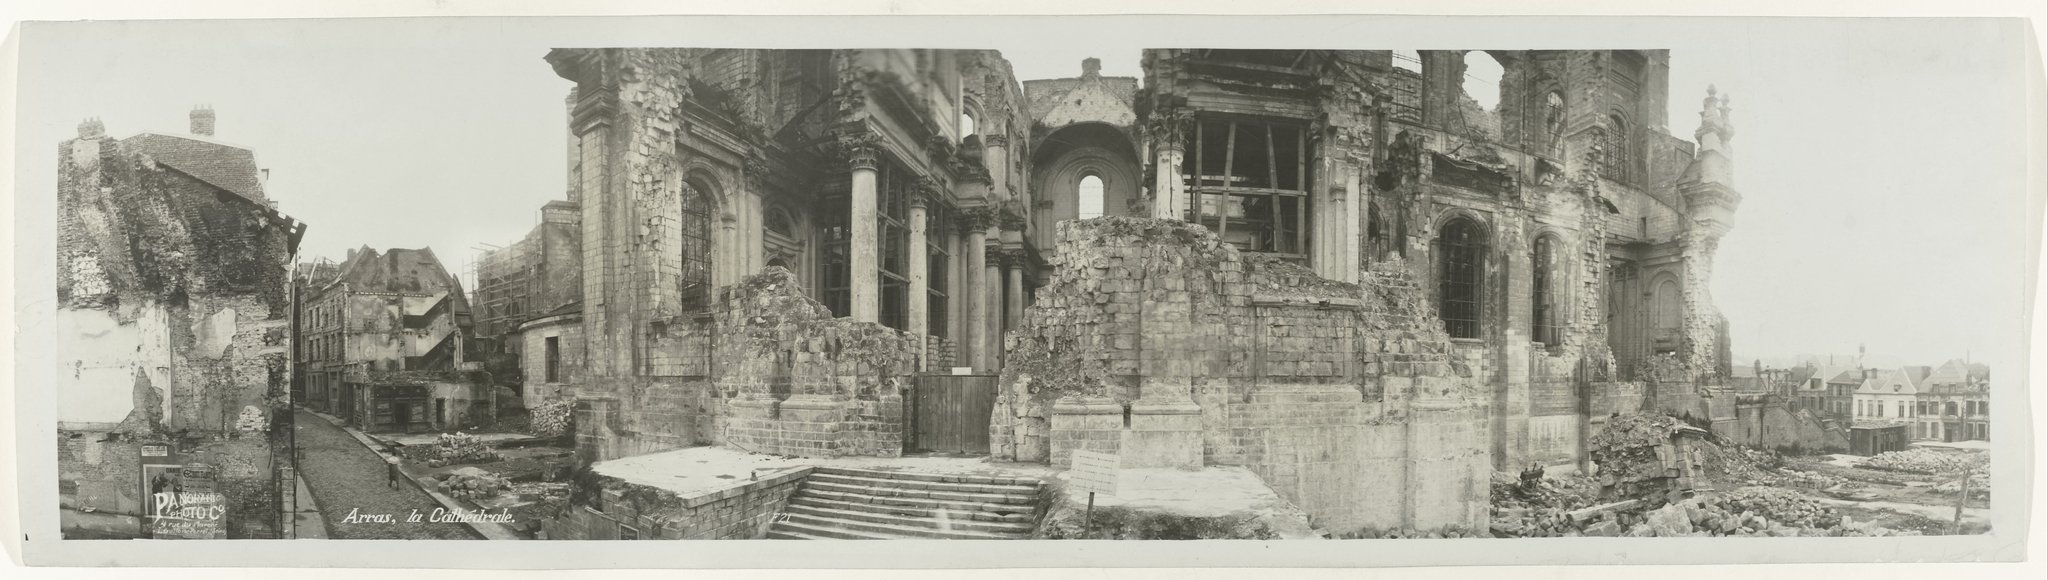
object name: photograph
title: Oorlogsschade in Arras (Frankrijk) na afloop van de Eerste Wereldoorlog ('Arras, la Cathédrale')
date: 1918-1919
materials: photographic support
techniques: gelatin silver print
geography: arras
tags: devastated, ruined place or city (~ warfare)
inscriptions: title: ‘Arras, la Cathédrale // F21’, signature: ‘PANORAMIC / PHOTO Co. / 4 rue du Marché / Levallois-Perret (Seine)’